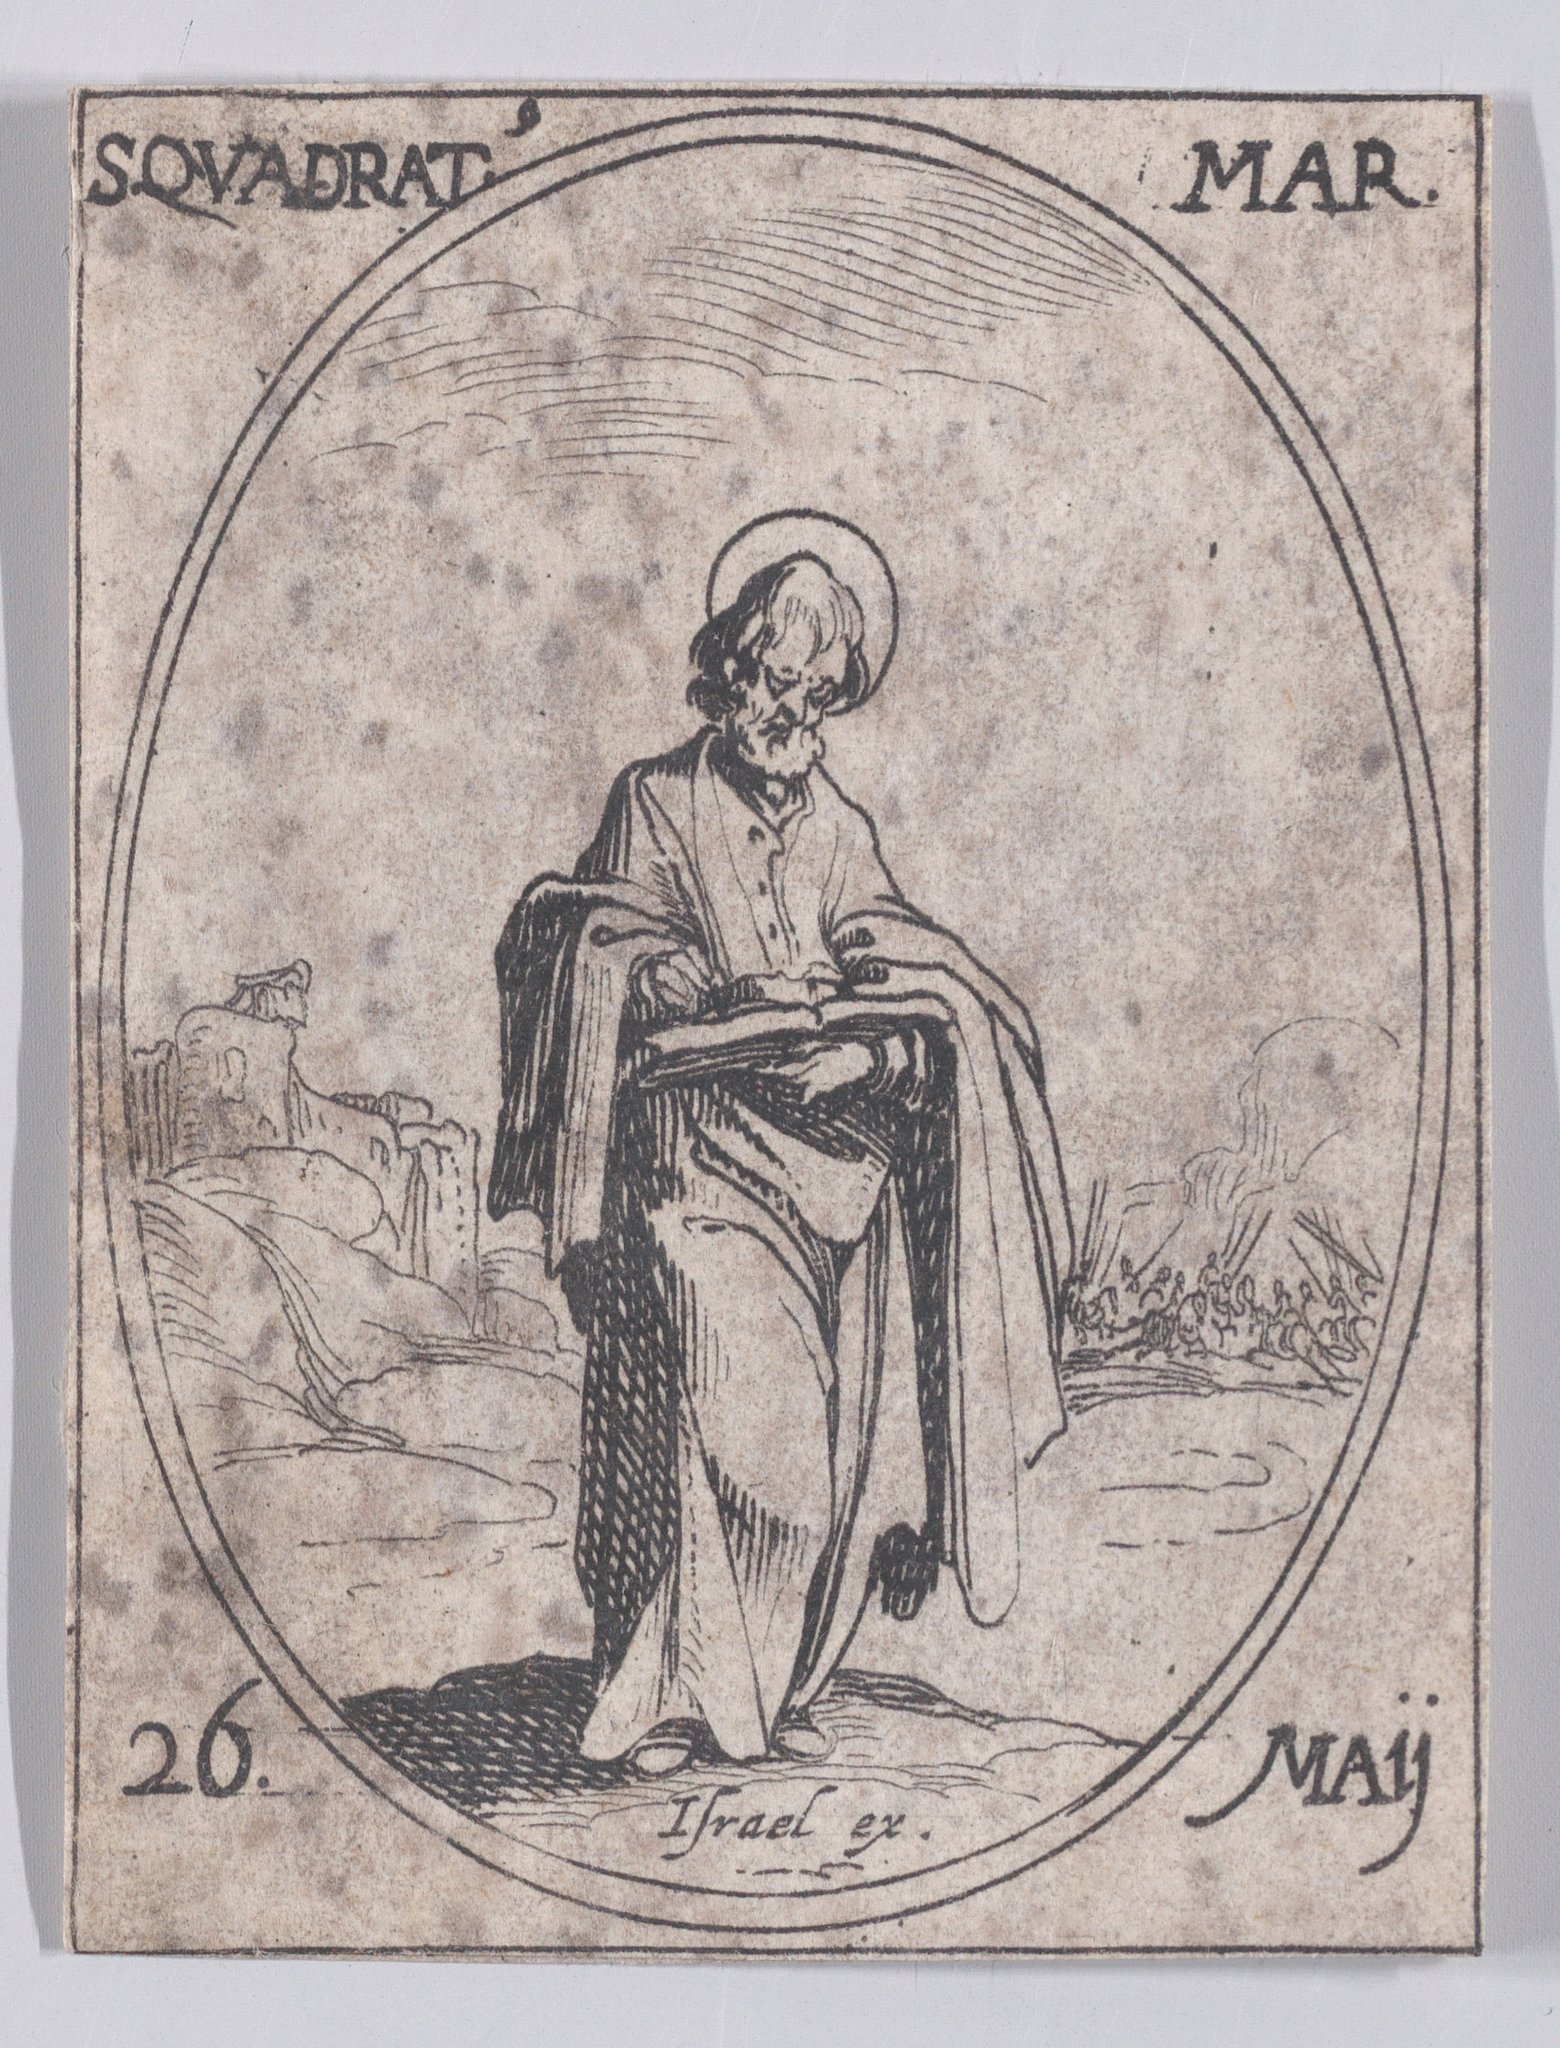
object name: print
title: S. Quadrat, martyr (St. Quadratus, Martyr), May 26th, from "Les Images De Tous Les Saincts et Saintes de L'Année" (Images of All of the Saints and Religious Events of the Year)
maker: jacques callot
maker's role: artist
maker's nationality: french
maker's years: 1592-1635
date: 1636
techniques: etching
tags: men,saints